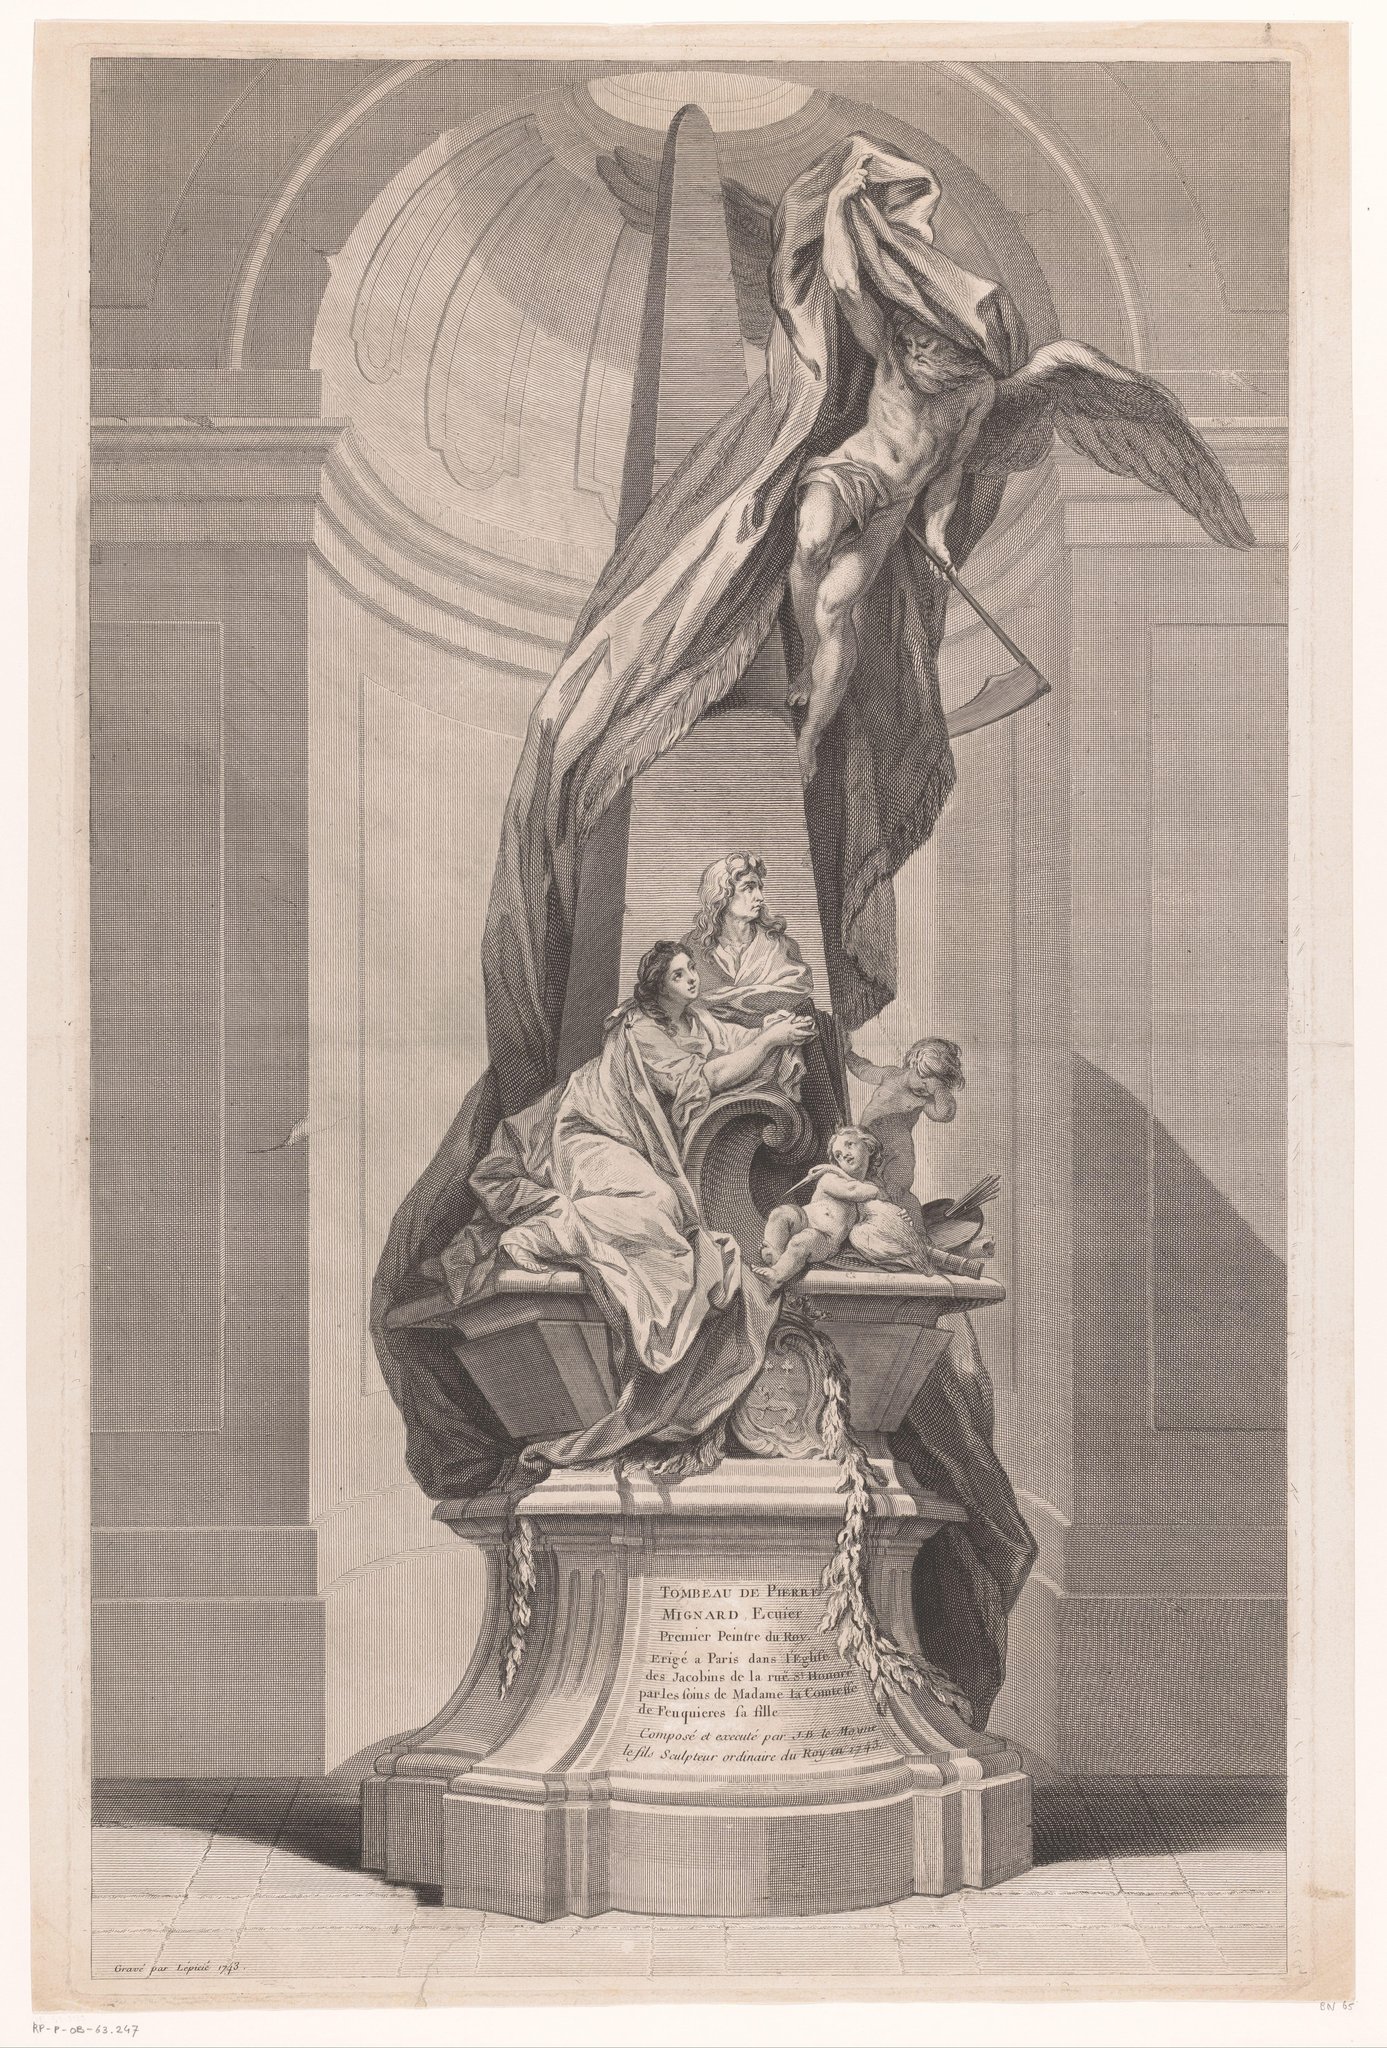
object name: print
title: Grafmonument van Pierre Mignard in het Couvent des Jacobins de la rue Saint-Honoré te Parijs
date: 1743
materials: paper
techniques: engraving, etching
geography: france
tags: pierre mignard, historical persons, grave, tomb, father time, man with wings and scythe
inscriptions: collector's mark: Lugt 240